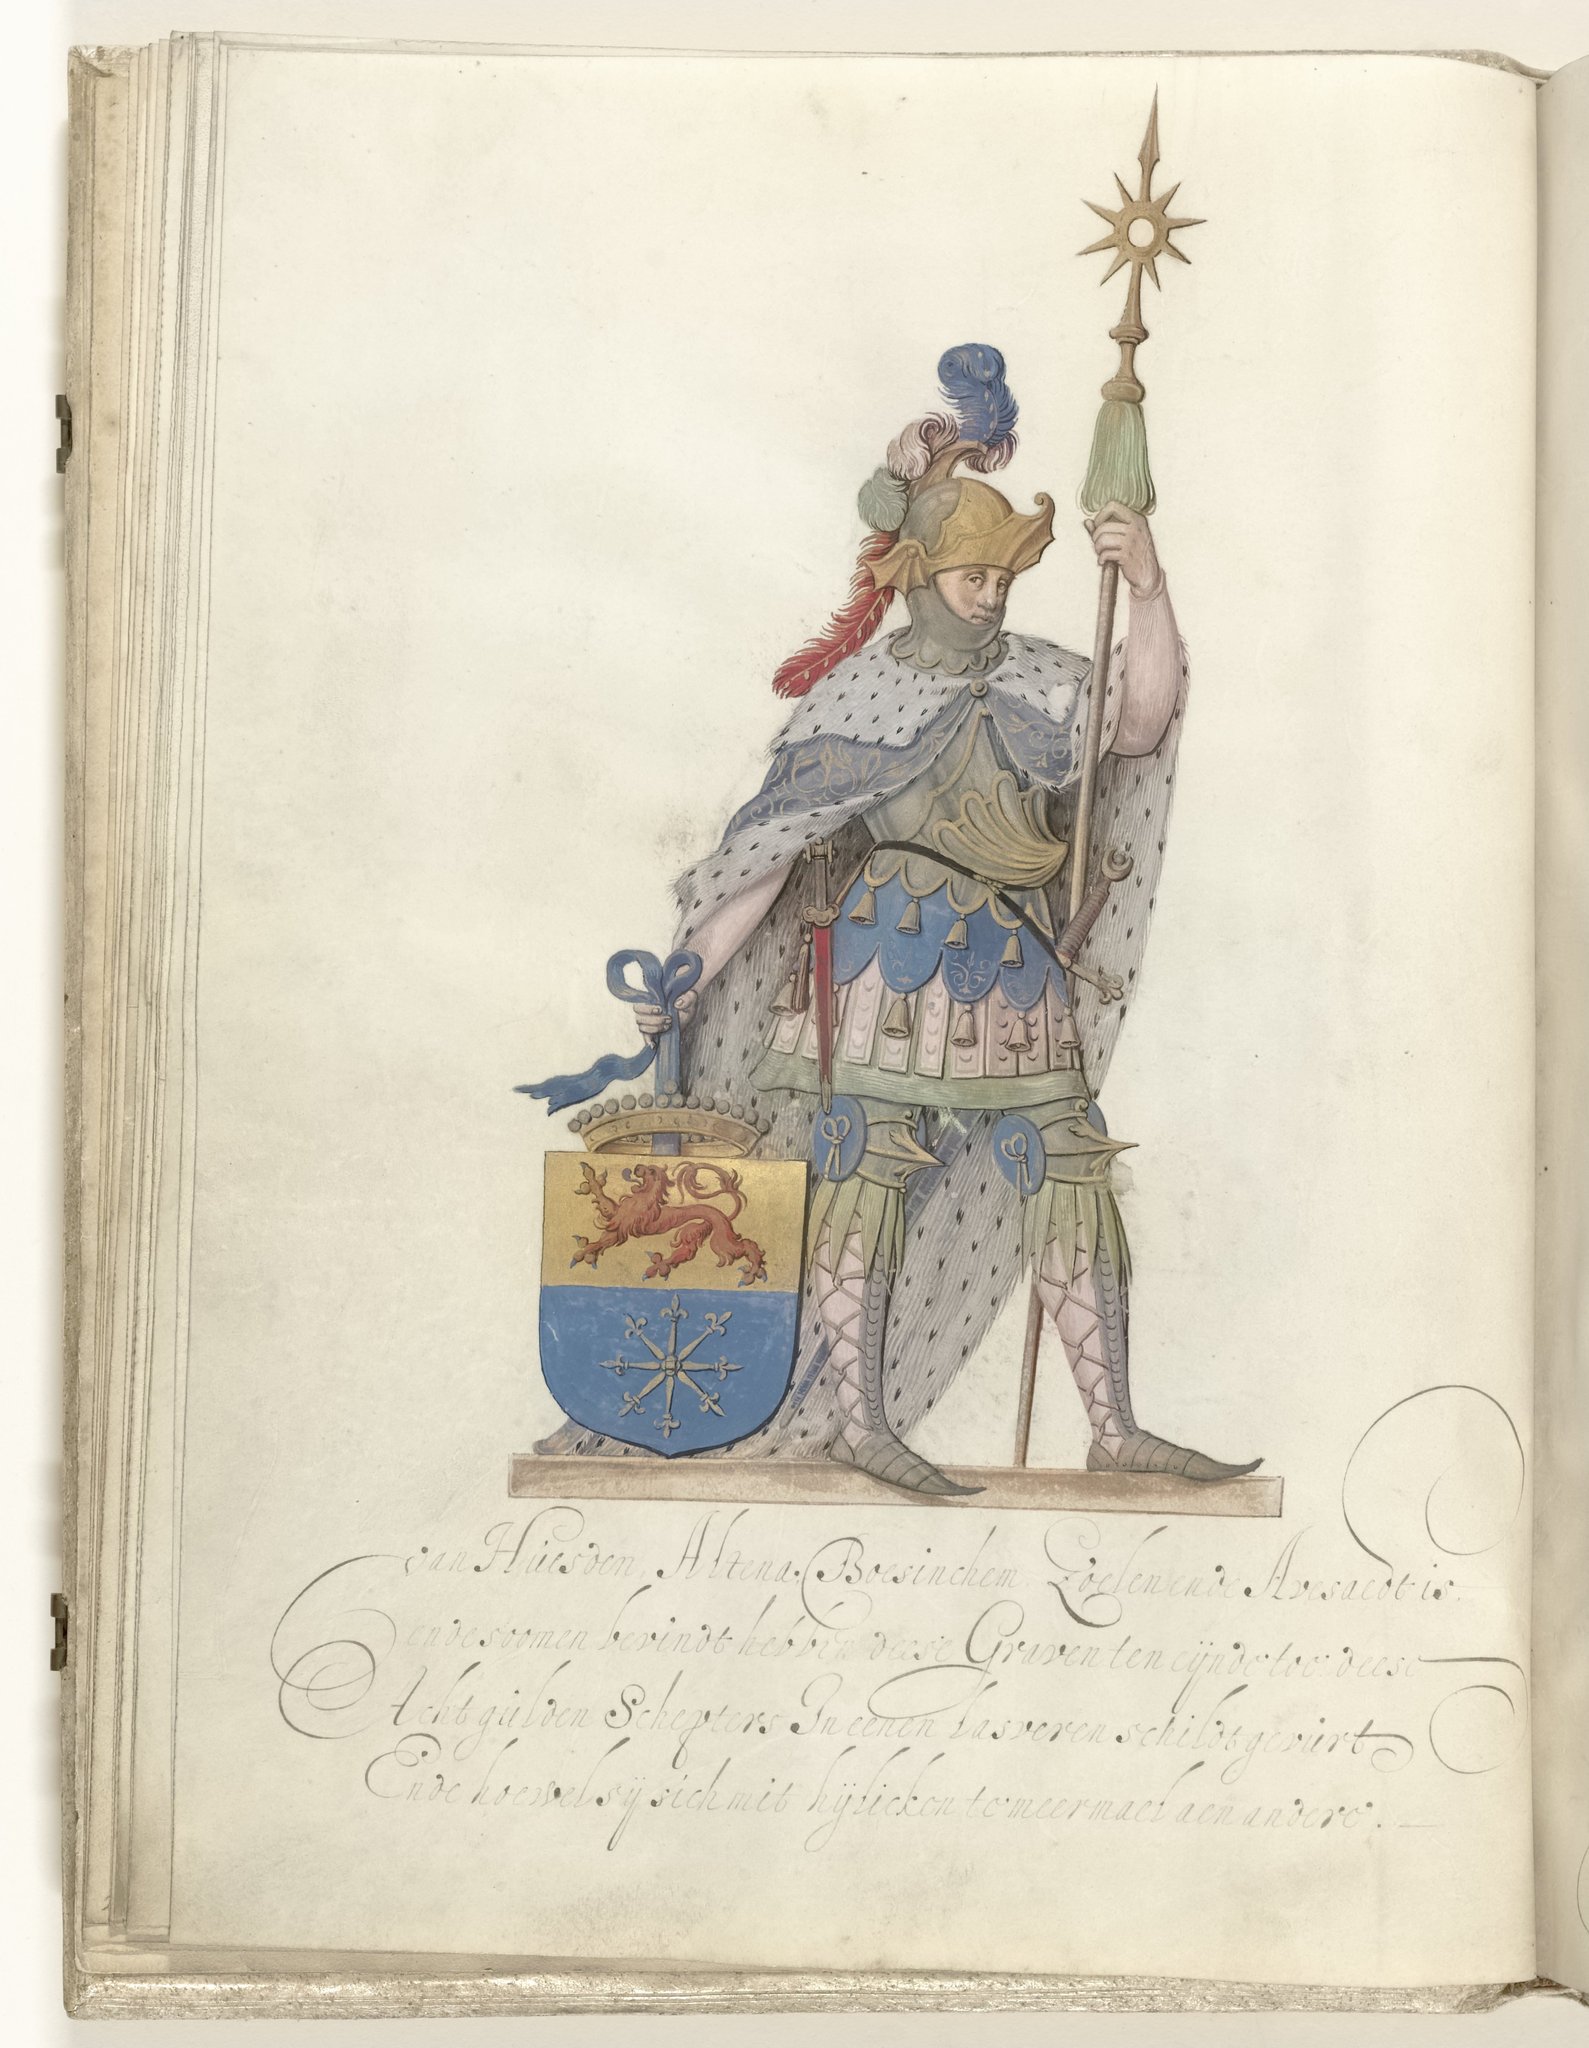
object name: drawing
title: Graaf Dirk van Teisterbant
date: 1590-1593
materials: paint, gouache, ink, parchment, watercolor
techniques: writing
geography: northern netherlands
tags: culemborg, heren en graven van, dirk graaf van teisterbant, graven van teisterbant, culemborg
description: Dirk, graaf van Teisterbant, ca. 867. Staande ten voeten uit, in wapenrusting, speer in de linkerhand, het gedeelde wapen van Teisterbant en Aquitanië (?) aan een lint in de rechterhand. Onderdeel van geïllustreerd handschrift met de genealogie van de heren en graven van Culemborg.